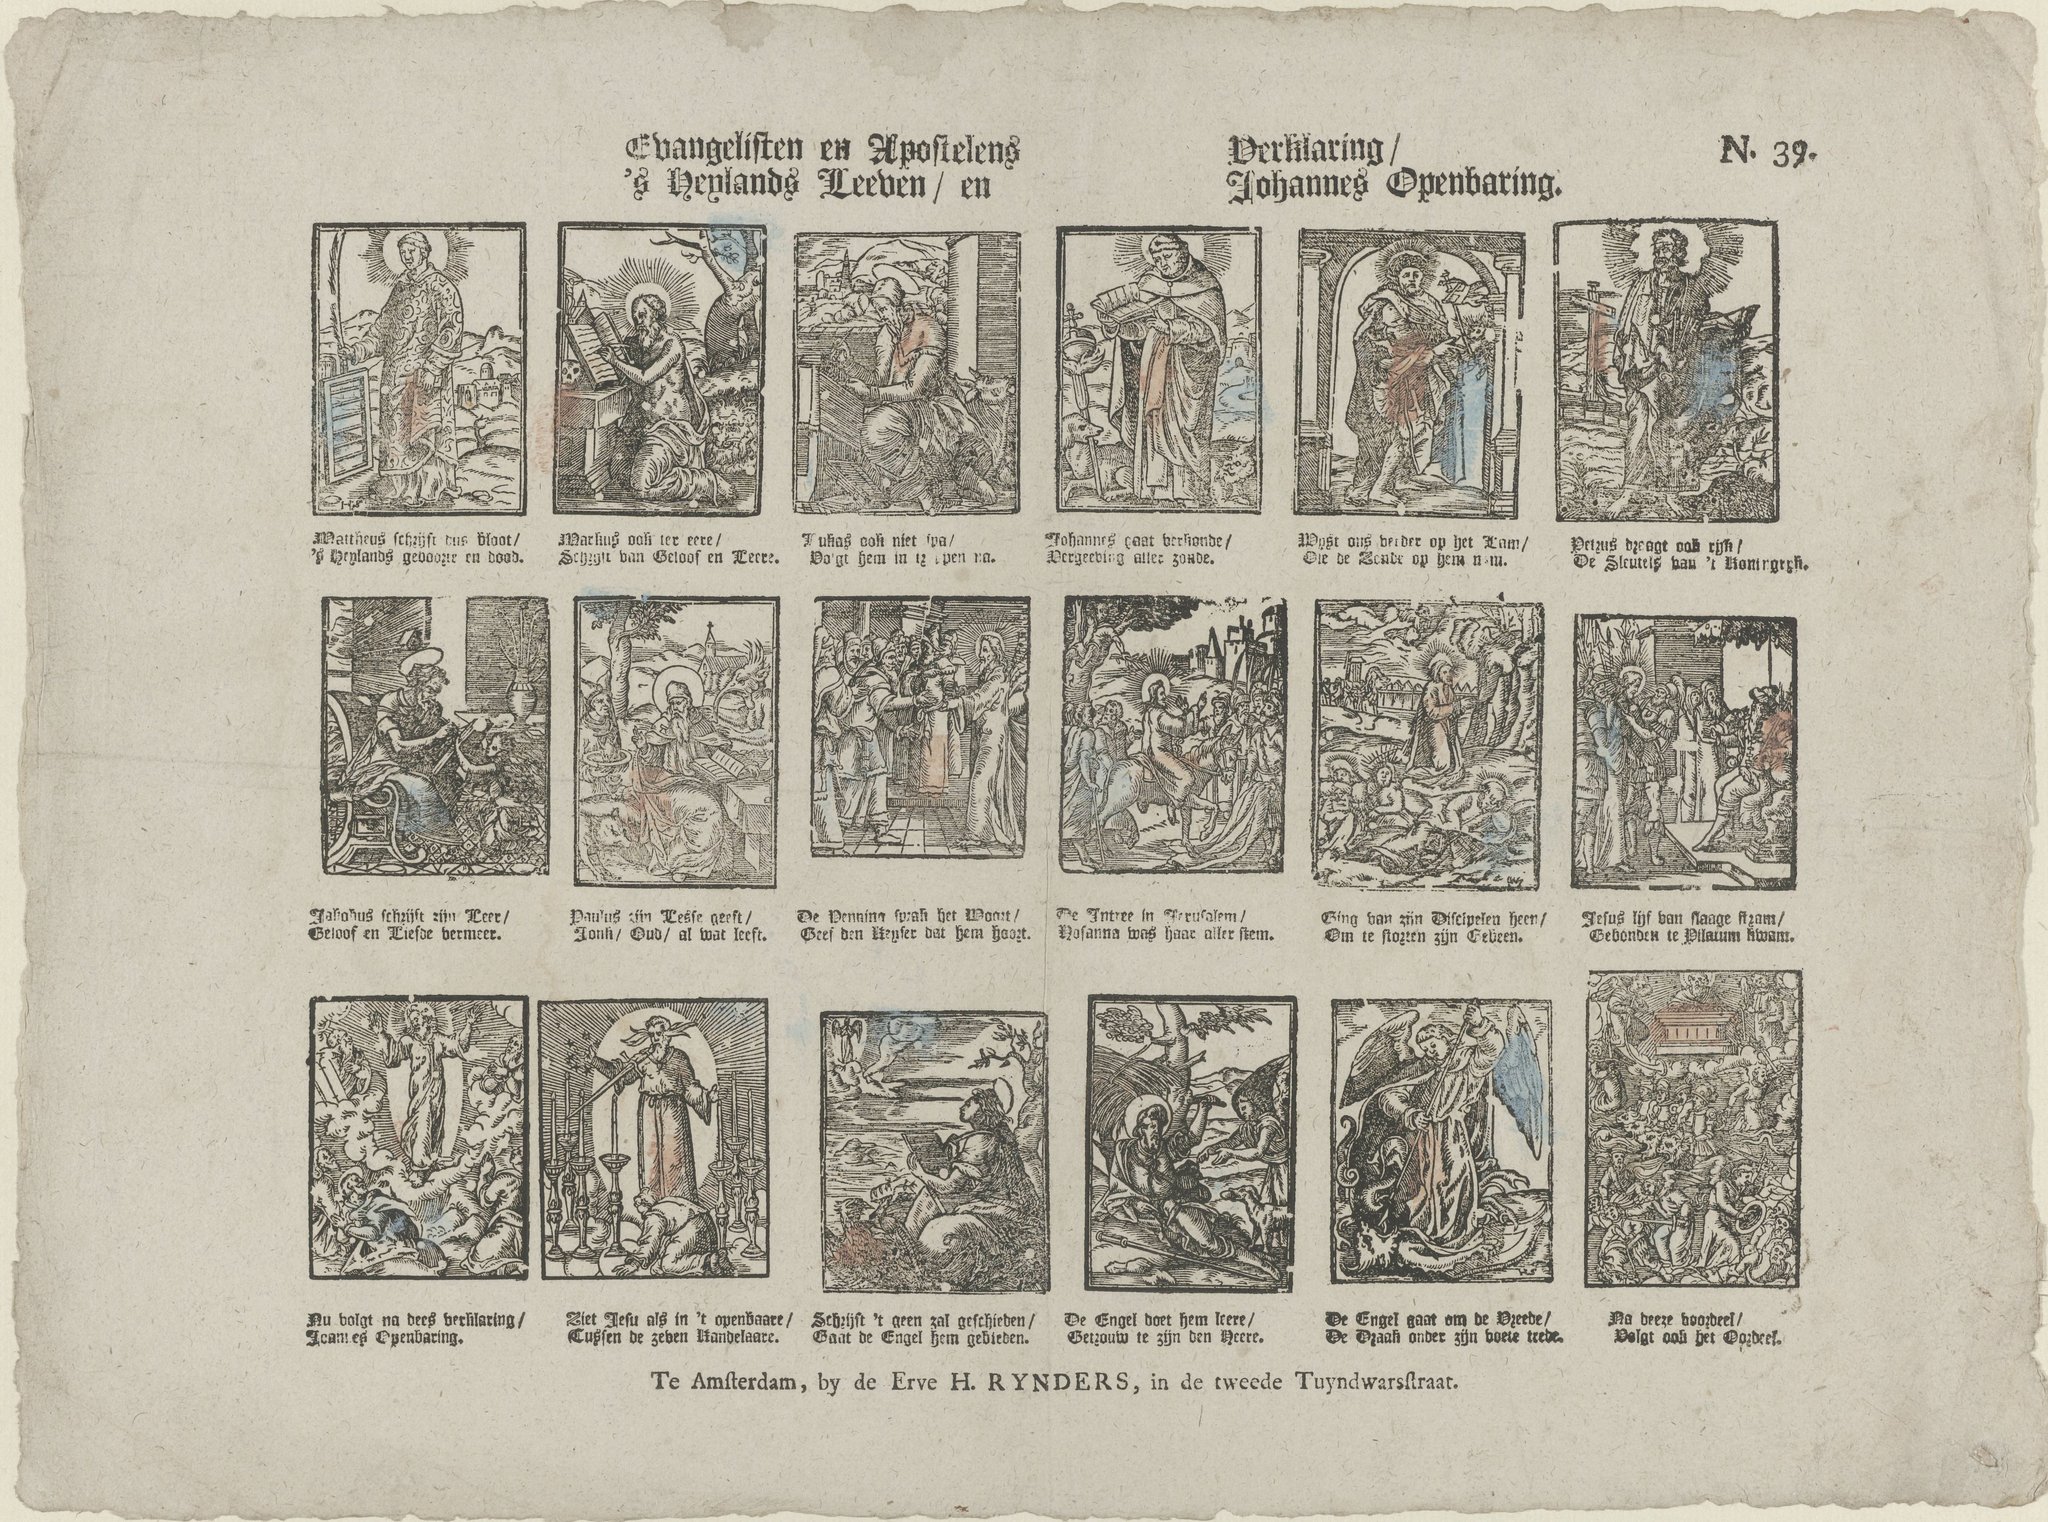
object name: print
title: Evangelisten en apostelens verklaring / 's Heylands leeven / Johannes openbaring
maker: christoffel van sichem (i)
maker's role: print maker, publisher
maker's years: 1546-1624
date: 1831-1854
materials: paper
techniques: colour, letterpress printing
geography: amsterdam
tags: john (writing) on the island of patmos, possibly the eagle beside him, the four evangelists ~ the four main prophets, the revelation of john, the apocalypse, new testament, lives and acts of the apostles (part ii), lives and acts of the apostles (part i), series of scenes from the life of christ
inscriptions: collector's mark: Lugt 2760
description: Blad met 18 voorstellingen van de evangelisten, de apostelen, scènes uit het leven van Christus en de openbaring van Johannes. Onder elke afbeelding een tweeregelig vers. Genummerd rechtsboven: N. 39.